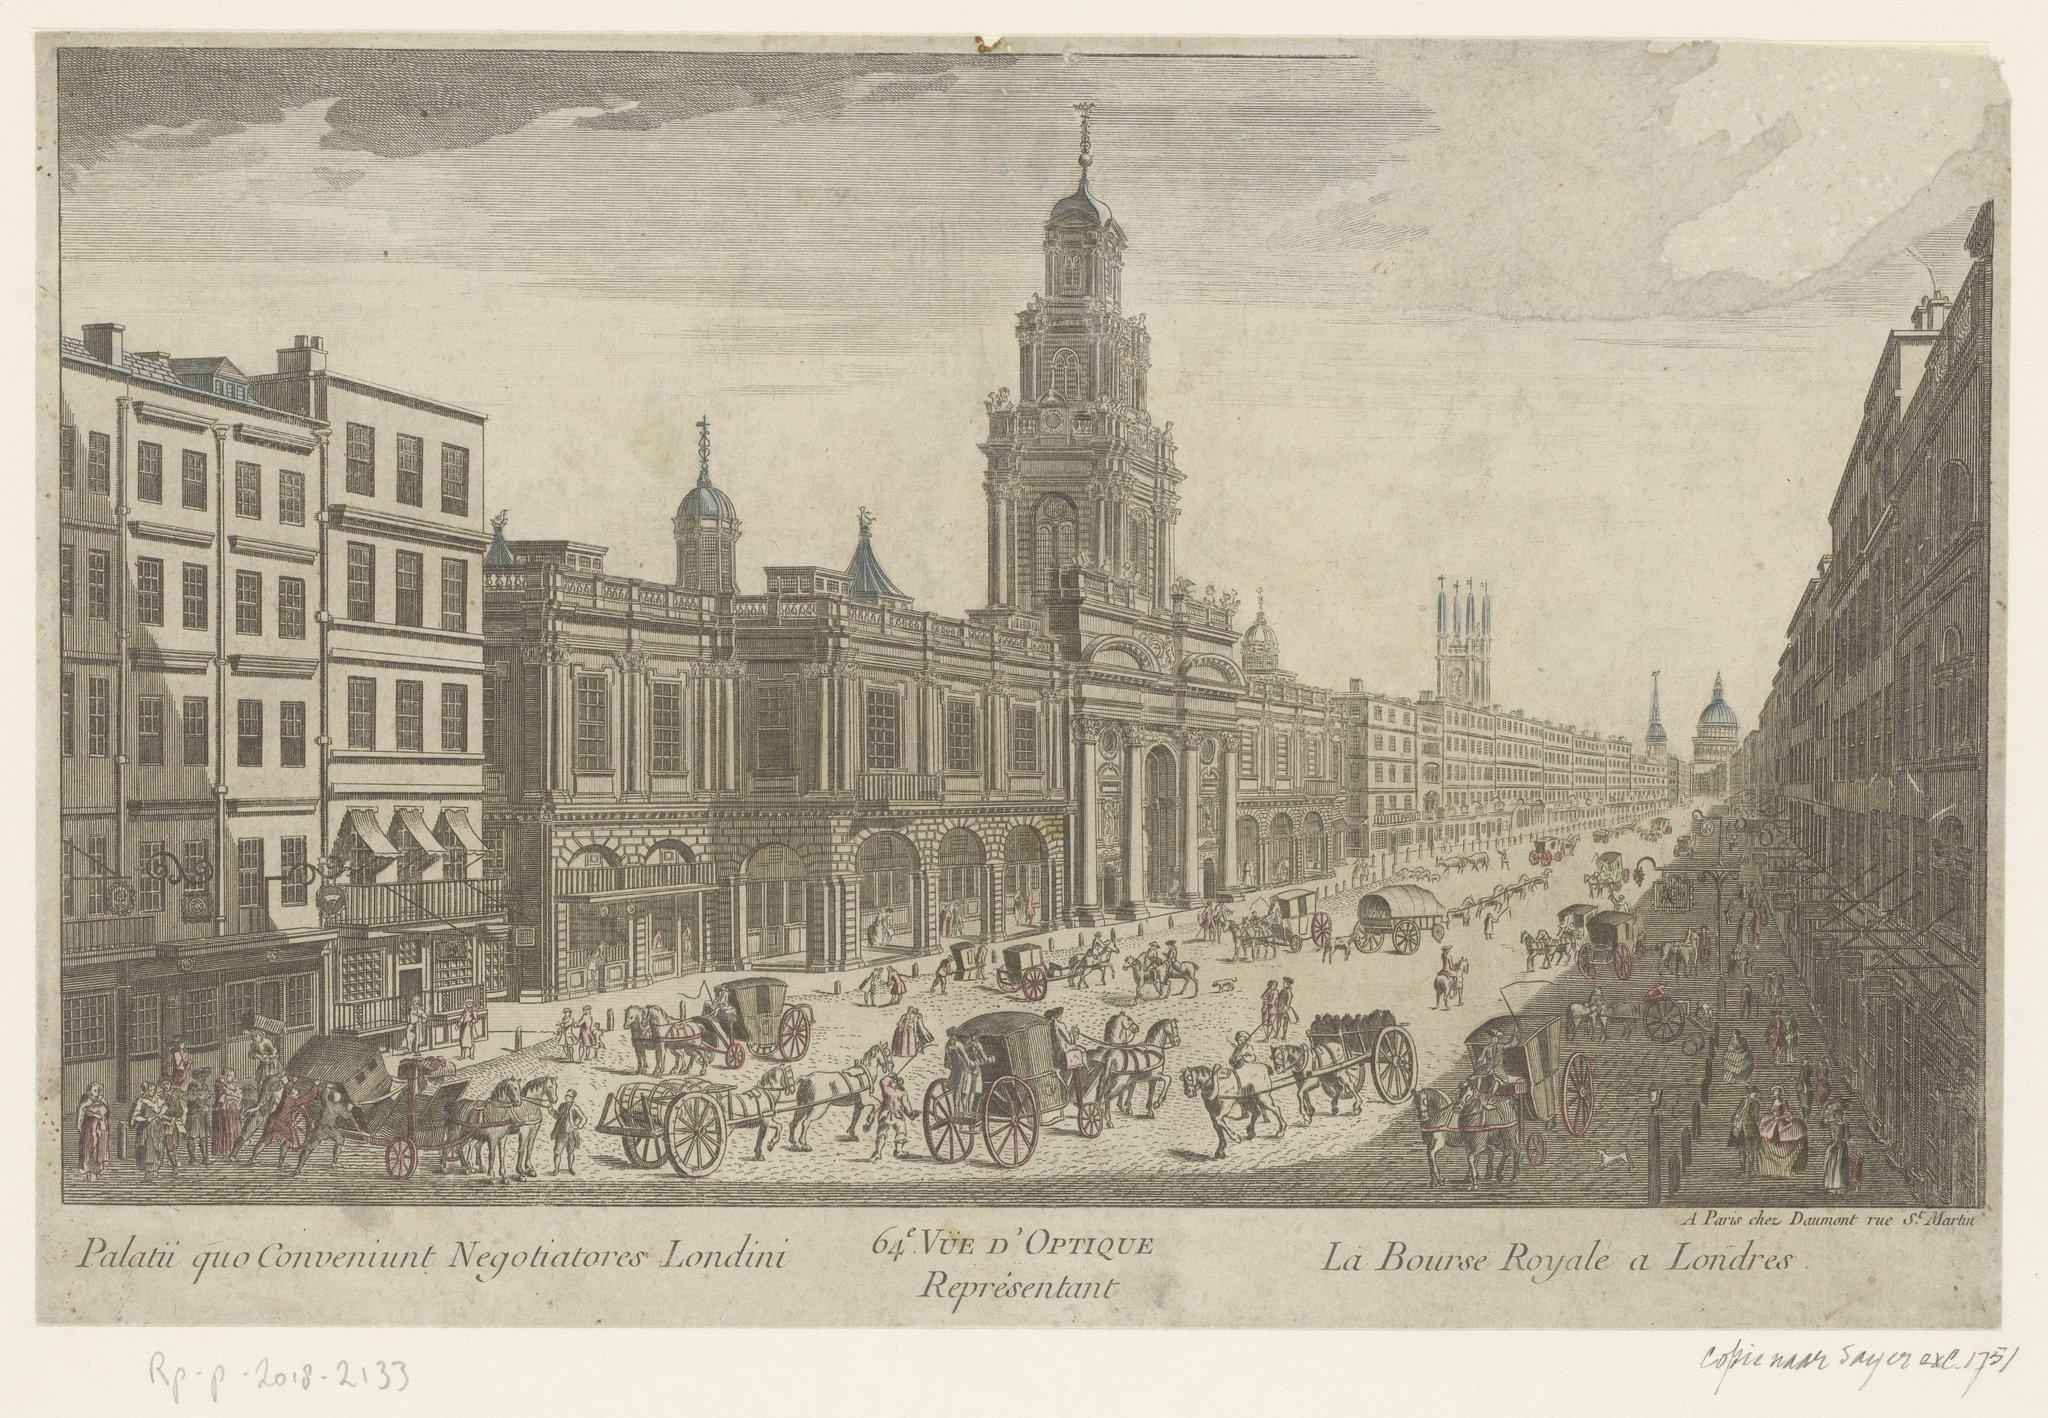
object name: print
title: Gezicht op de Royal Exchange, te Londen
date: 1745-1775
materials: paper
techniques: etching, hand coloring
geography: paris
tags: street, exchange, bourse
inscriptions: collector's mark: Lugt 2228